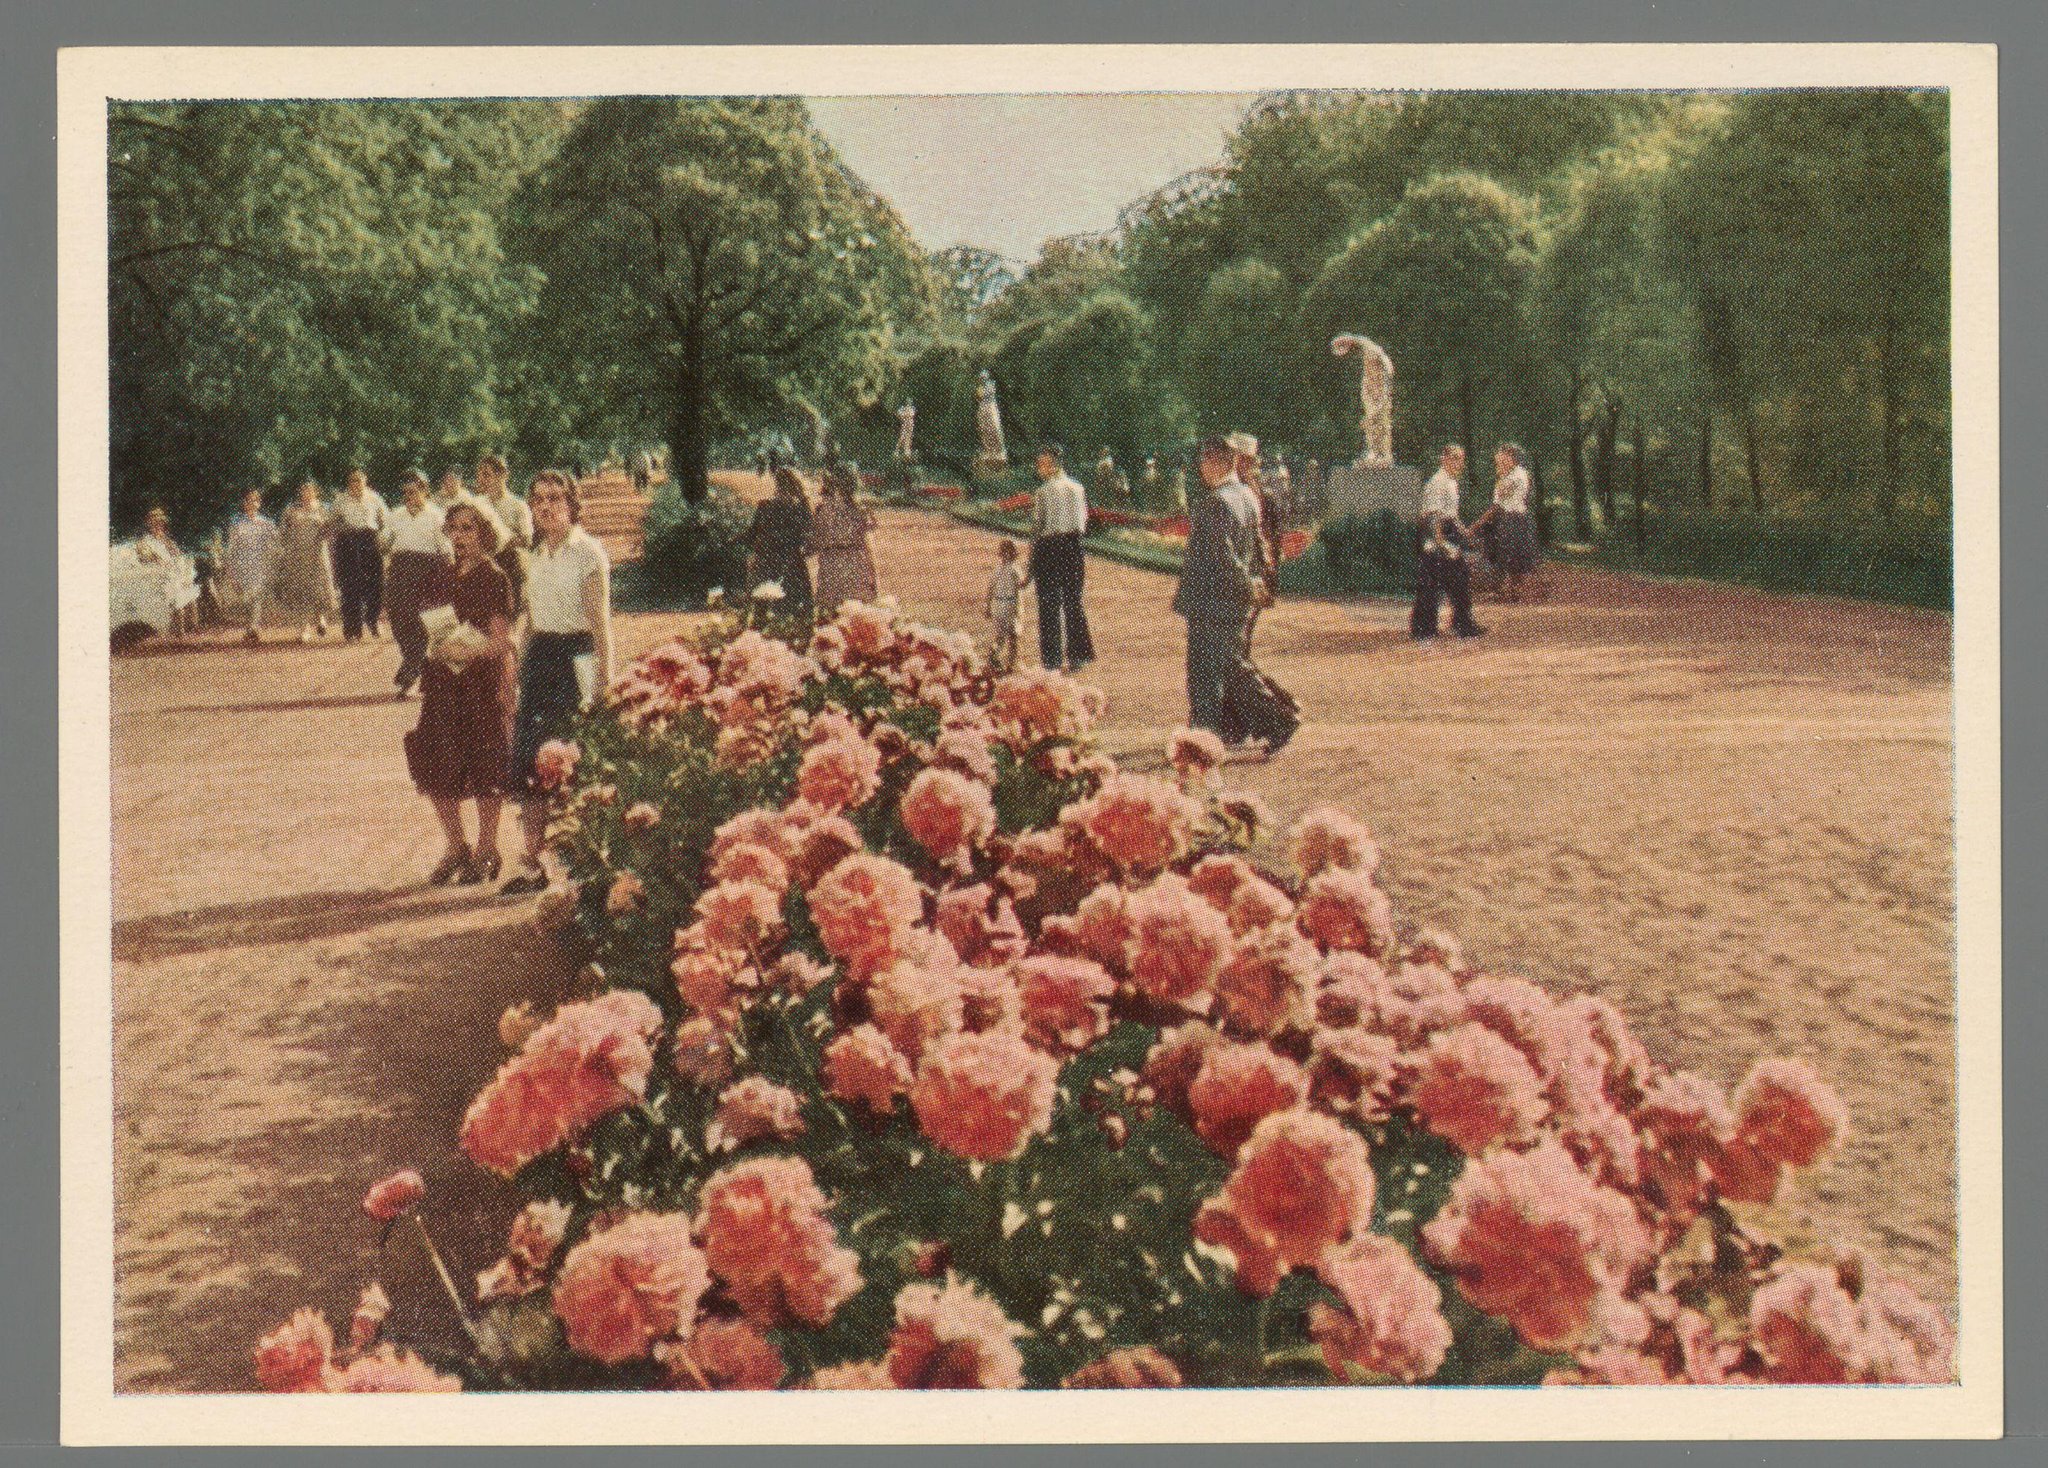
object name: photomechanical print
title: Moscow. The Gorky Central Recreation Park / Moskau. Im Zentralen Gorki-Park für Kultur und Erholung / Moscou. Au Parc de culture et de repos Gorki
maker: Anonymous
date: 1956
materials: cardboard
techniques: color autotype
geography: moscow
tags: park, garden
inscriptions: date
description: De titel op object staat ook in het Russisch.